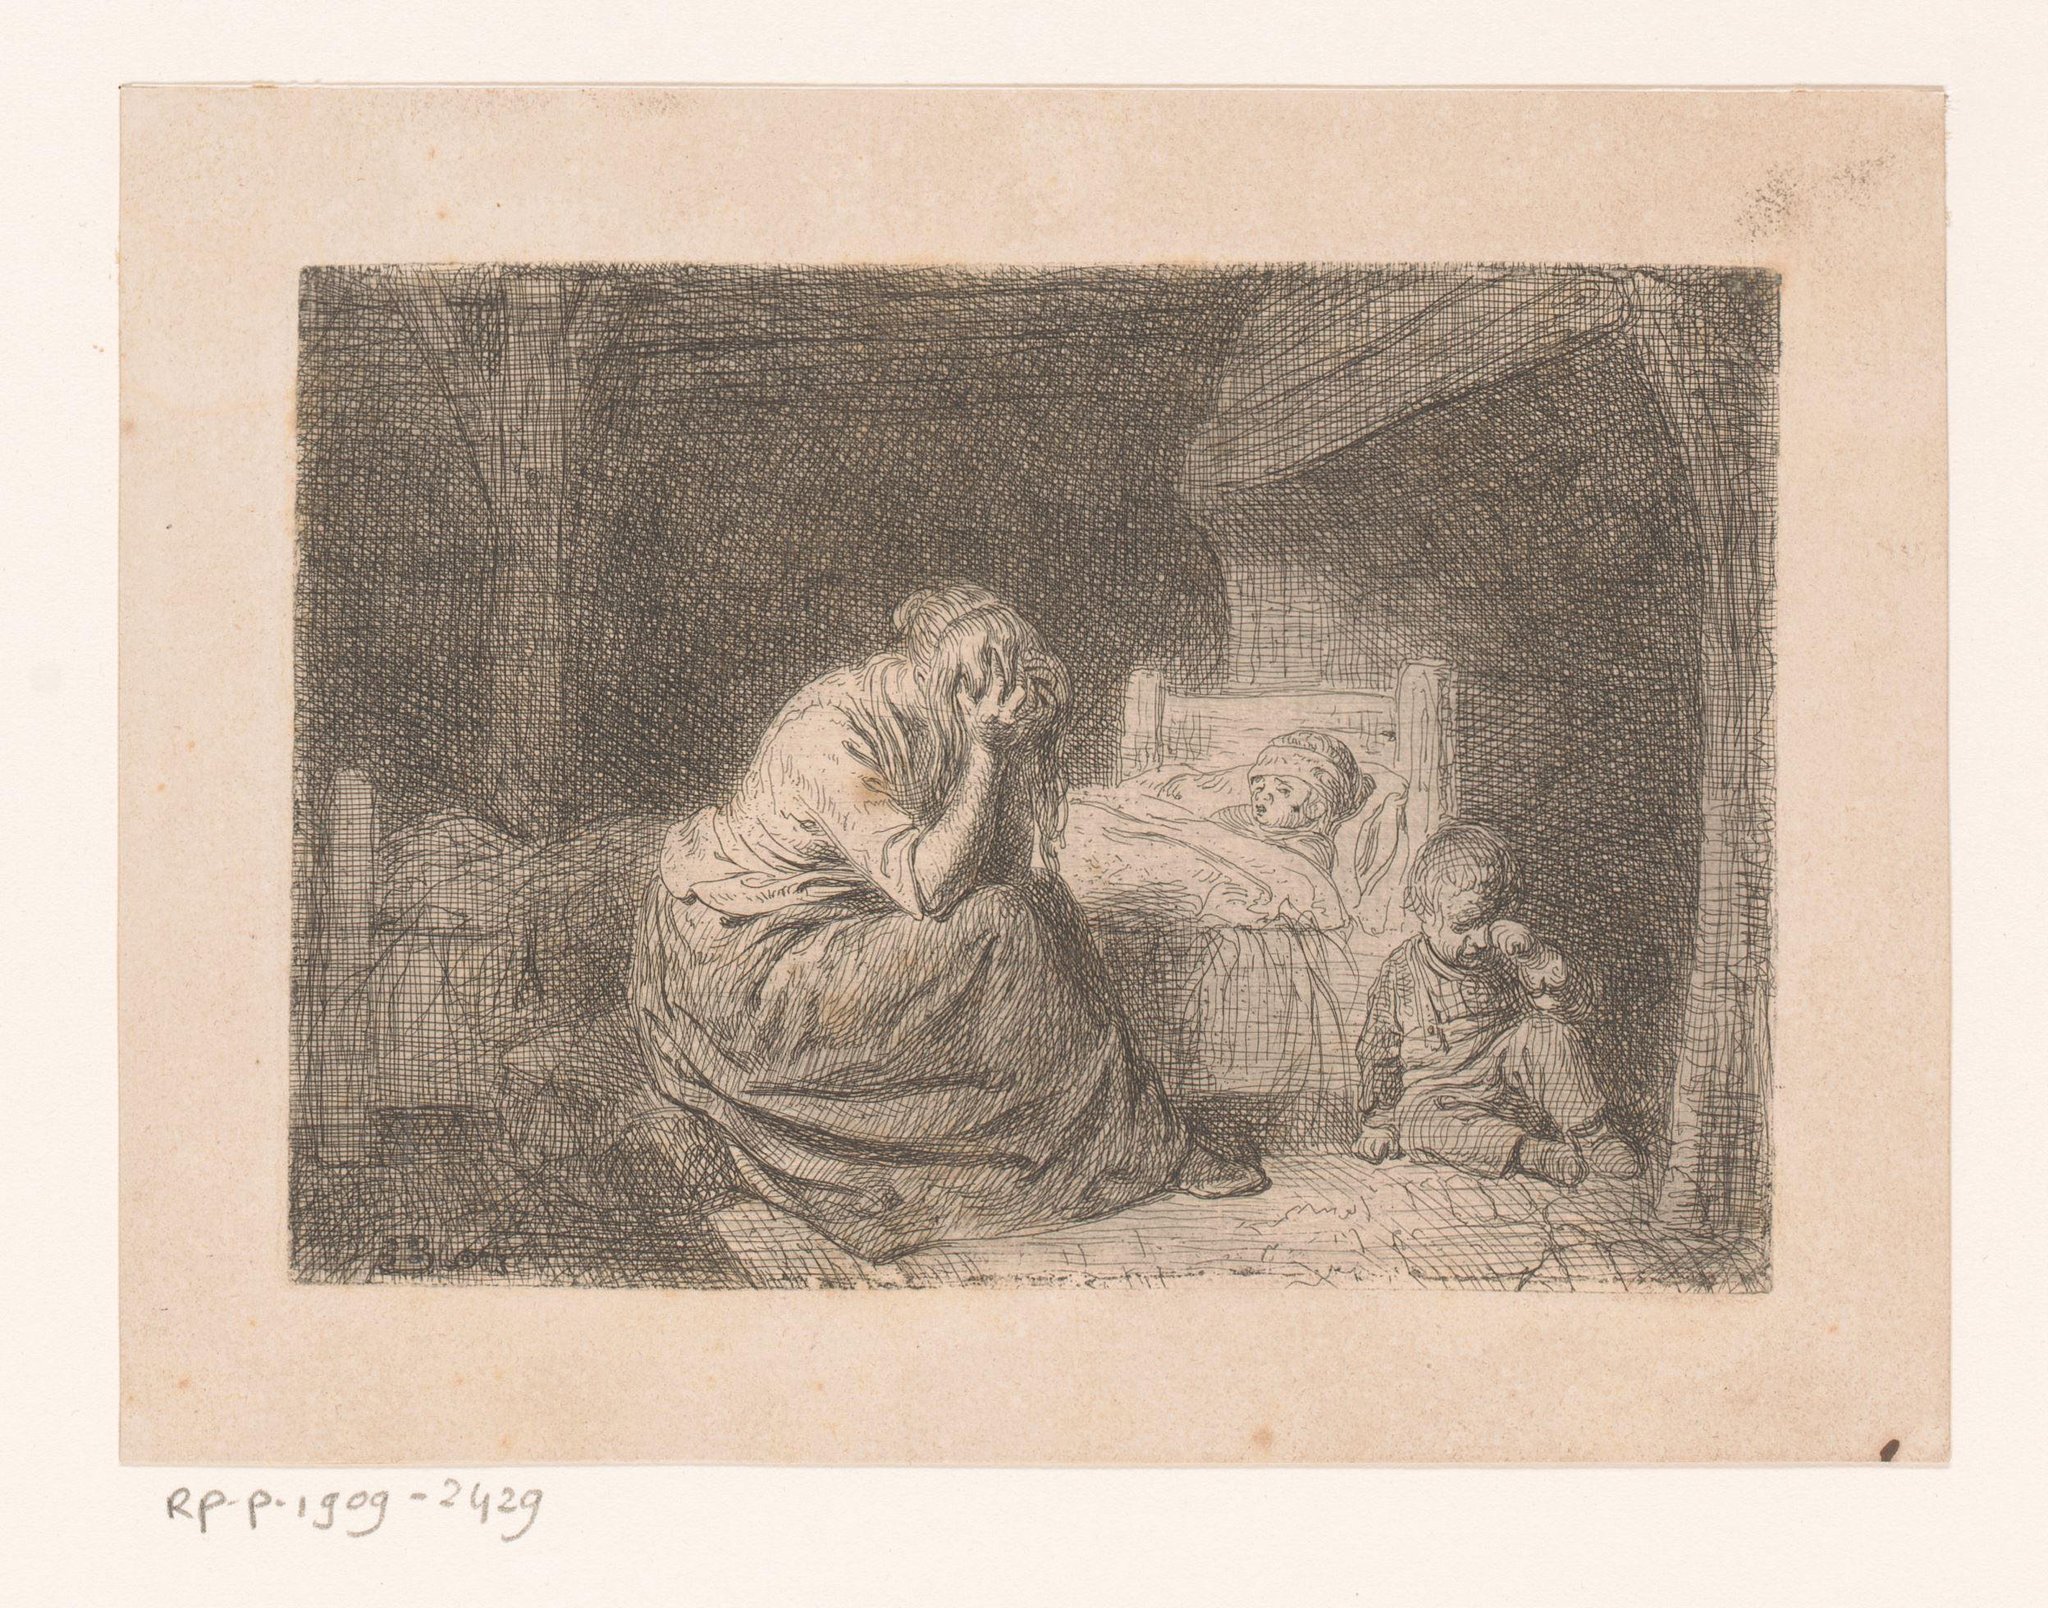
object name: print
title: Treurende moeder bij het ziekbed van een kind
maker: eugène françois de block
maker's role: draughtsman, painter, print maker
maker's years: 1812-1893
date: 1822-1893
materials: paper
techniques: etching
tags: sick-bed, mother and baby or young child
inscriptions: collector's mark: Lugt 2228, collector's mark: Lugt 1485